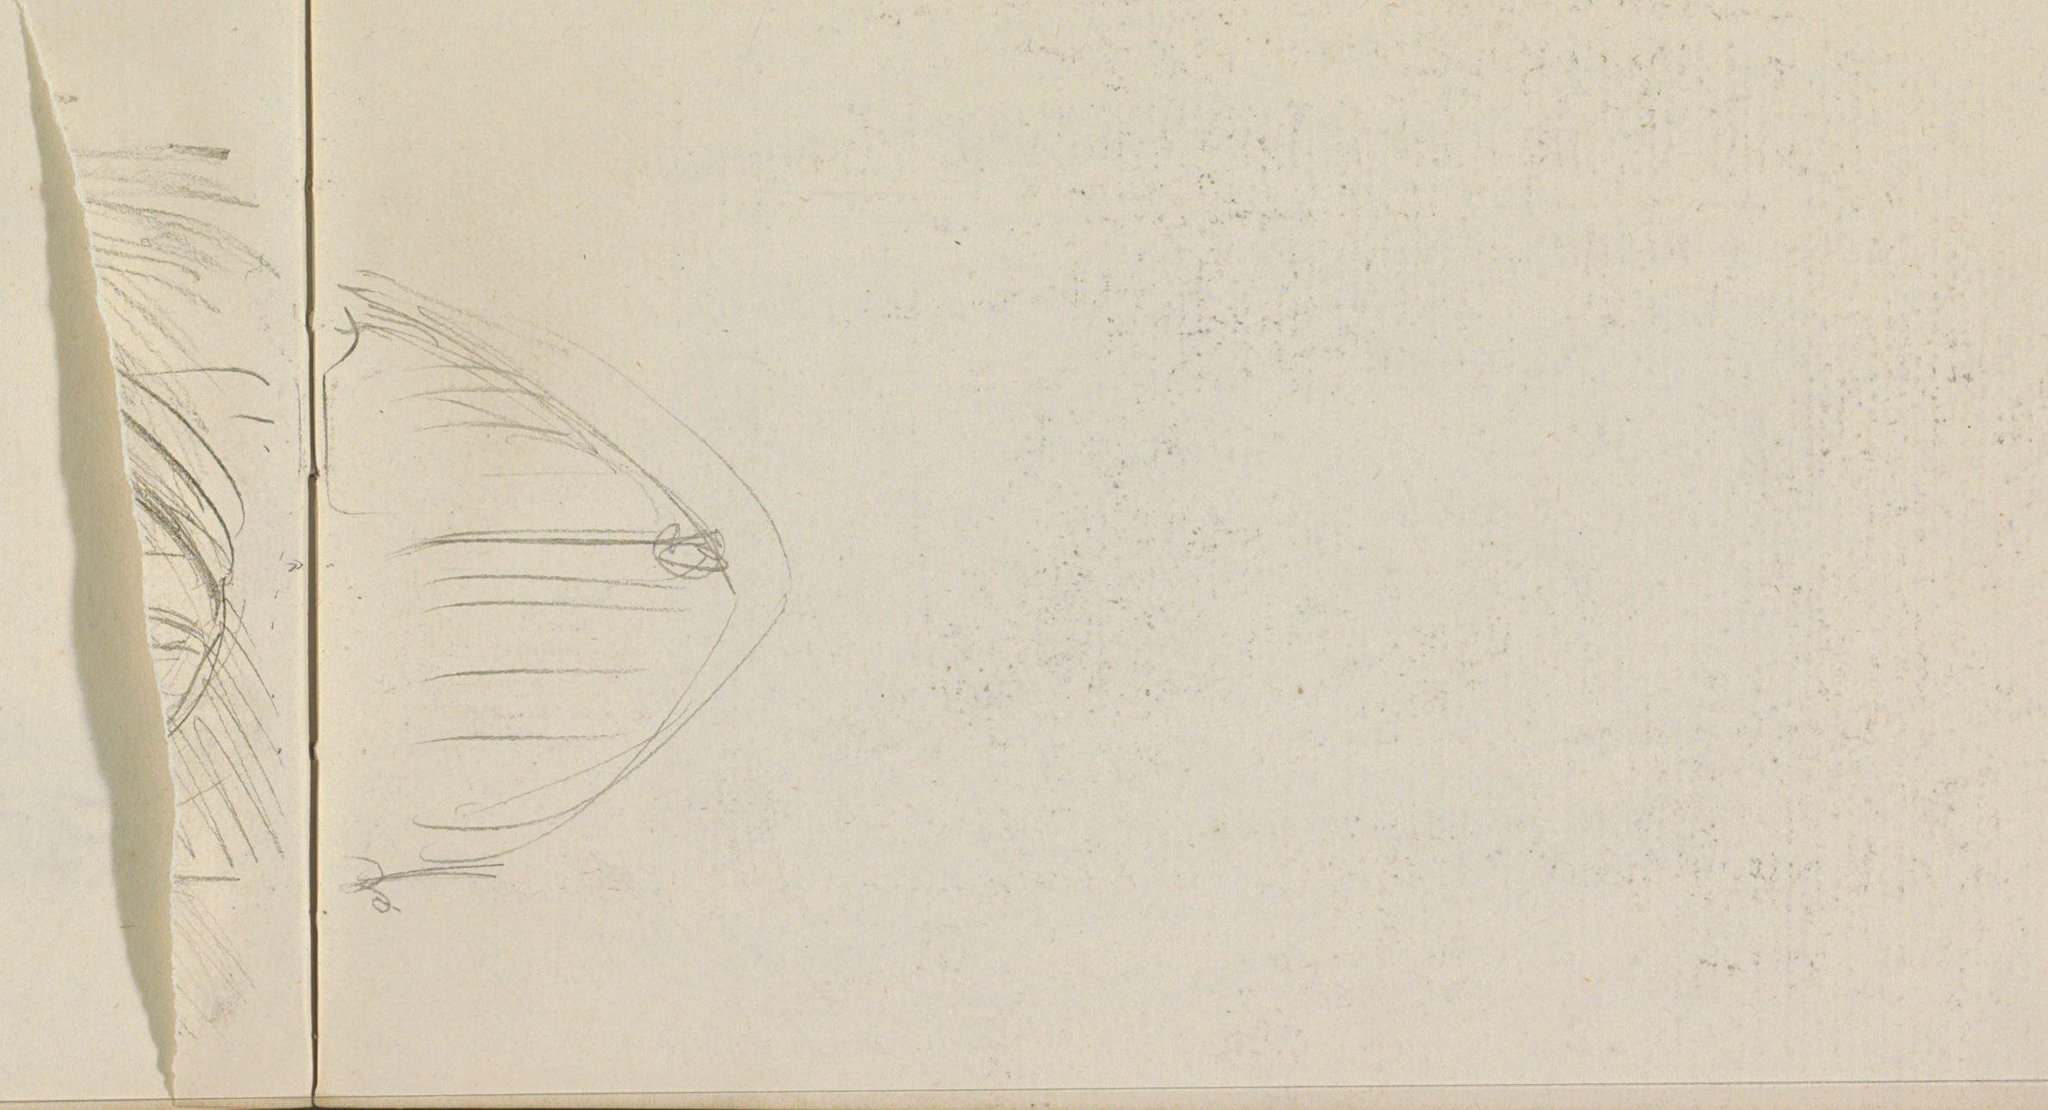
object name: sketchbook leaf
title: Studie, mogelijk een boeg van een roeiboot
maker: marius bauer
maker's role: draughtsman, print maker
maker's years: 1867-1932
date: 1902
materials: paper, pencil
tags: rowing-boat, canoe, etc.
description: Pagina 19 uit een schetsboek met 15 bladen.